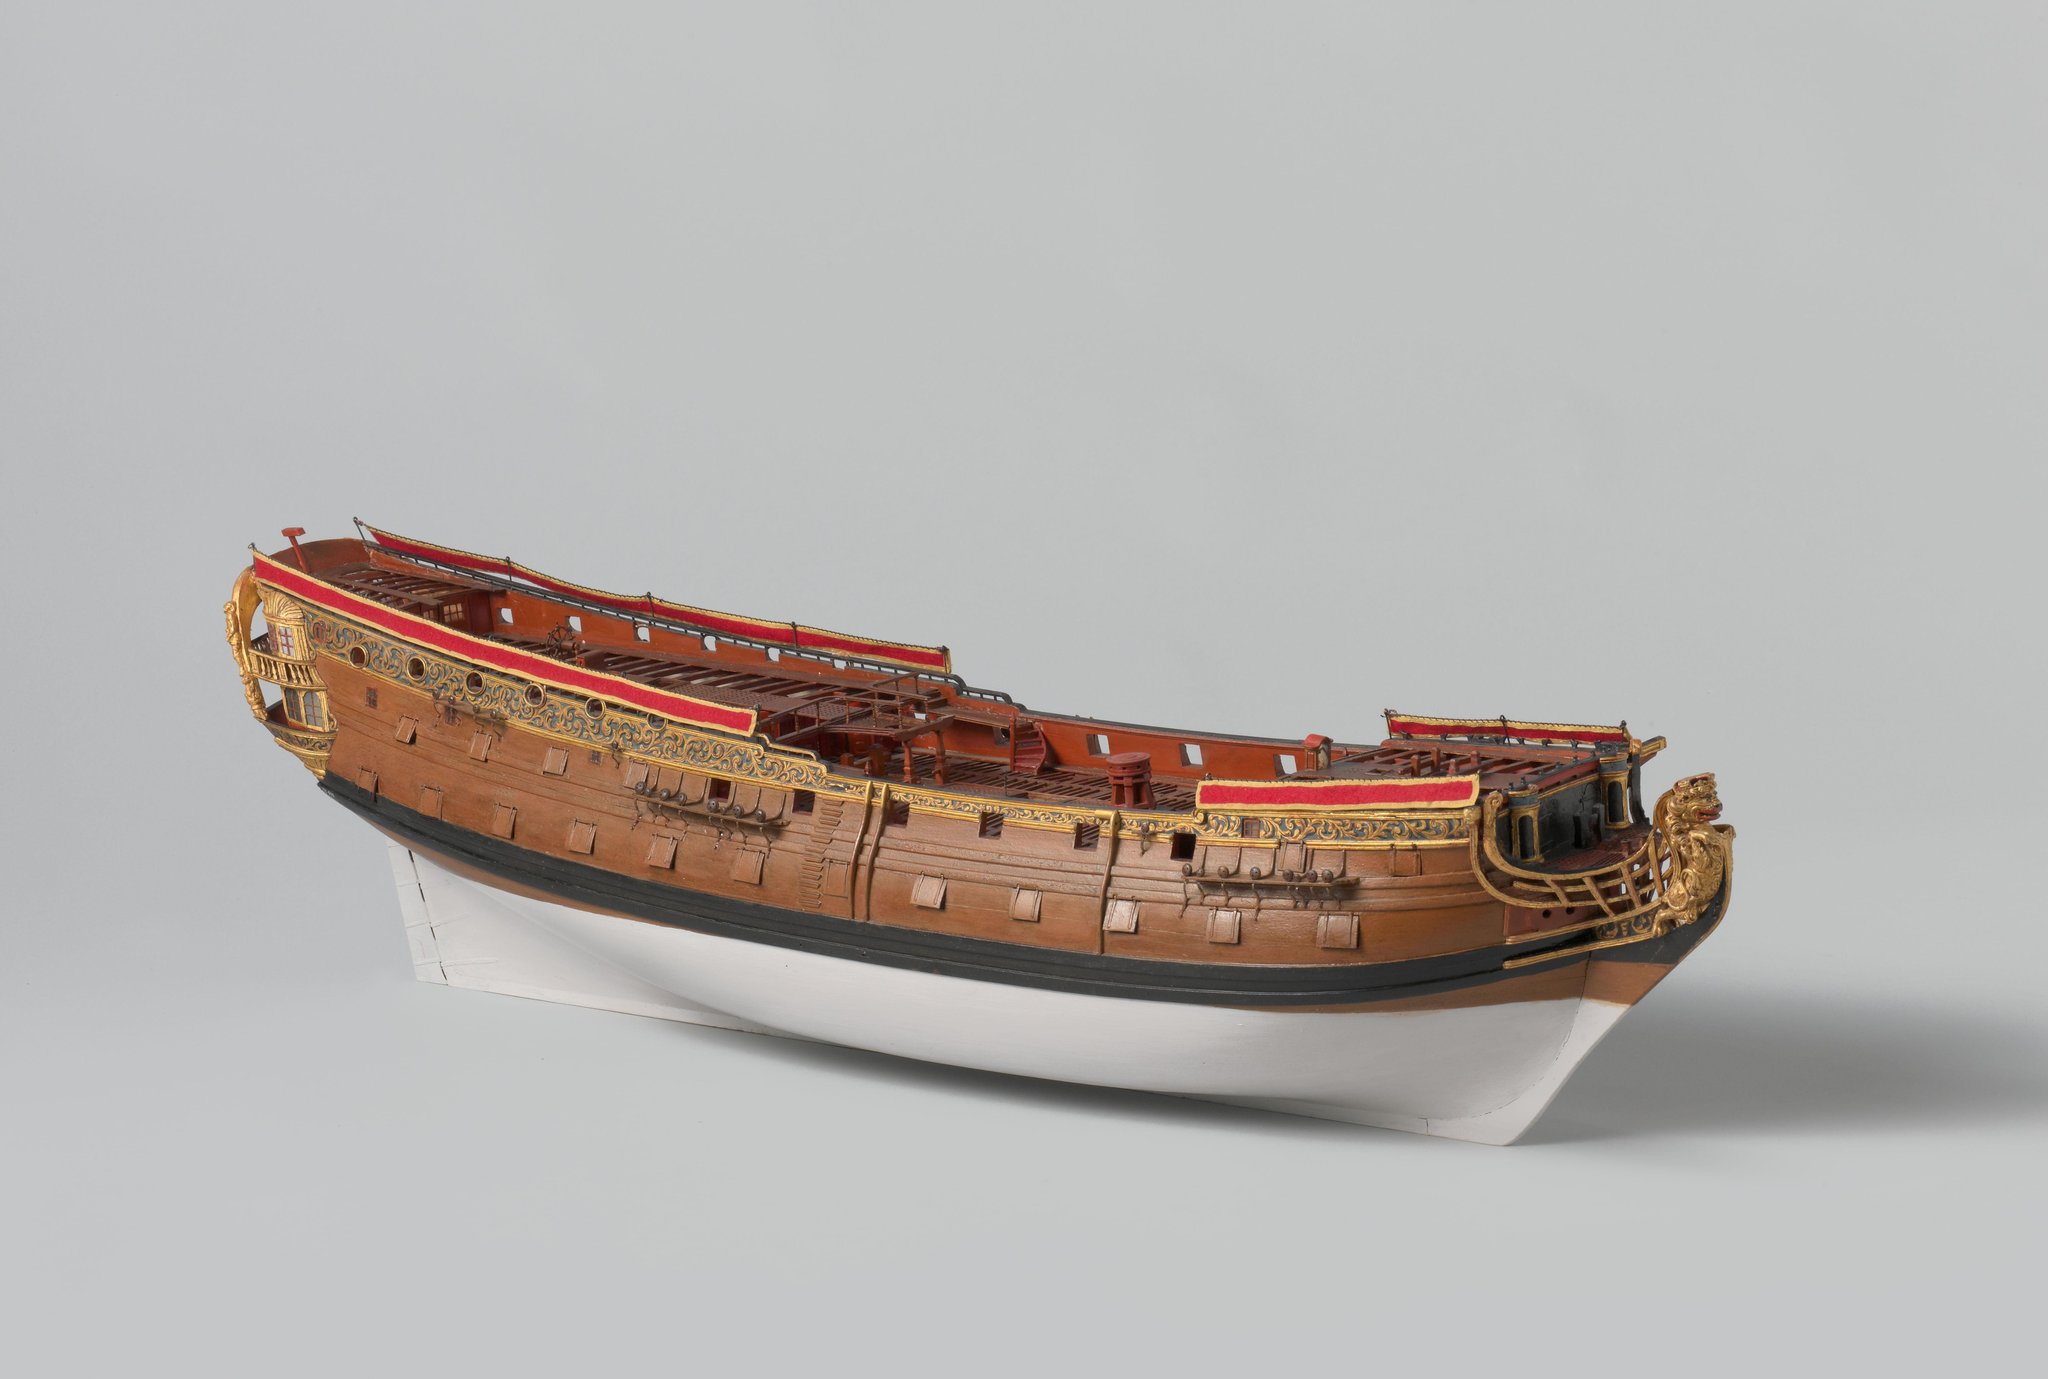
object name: hull model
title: Model of a 60-Gun Ship of the Line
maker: Anonymous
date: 1715-1720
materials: brass, textile, glass, paper, wood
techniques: polychromy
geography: united kingdom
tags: great britain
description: Het model stelt een Engels linieschip van het 4de charter voor. Bij een gebruikelijke schaal van 1:48 komen de verhoudingen exact overeen met het charter van 1719, dat tot 1733 gold, maar bepaalde aspecten wijzen op een zelfs iets vroeger datum. Hoewel het model naar Engelse begrippen vrij grof is uitgevoerd en de kwaliteit van stukken uit dezelfde periode niet eens benadert, is het belangrijk doordat het nauwkeurig de vorm, algemene constructie en uitrusting van een vroeg 18e-eeuws Engels linieschip weergeeft.